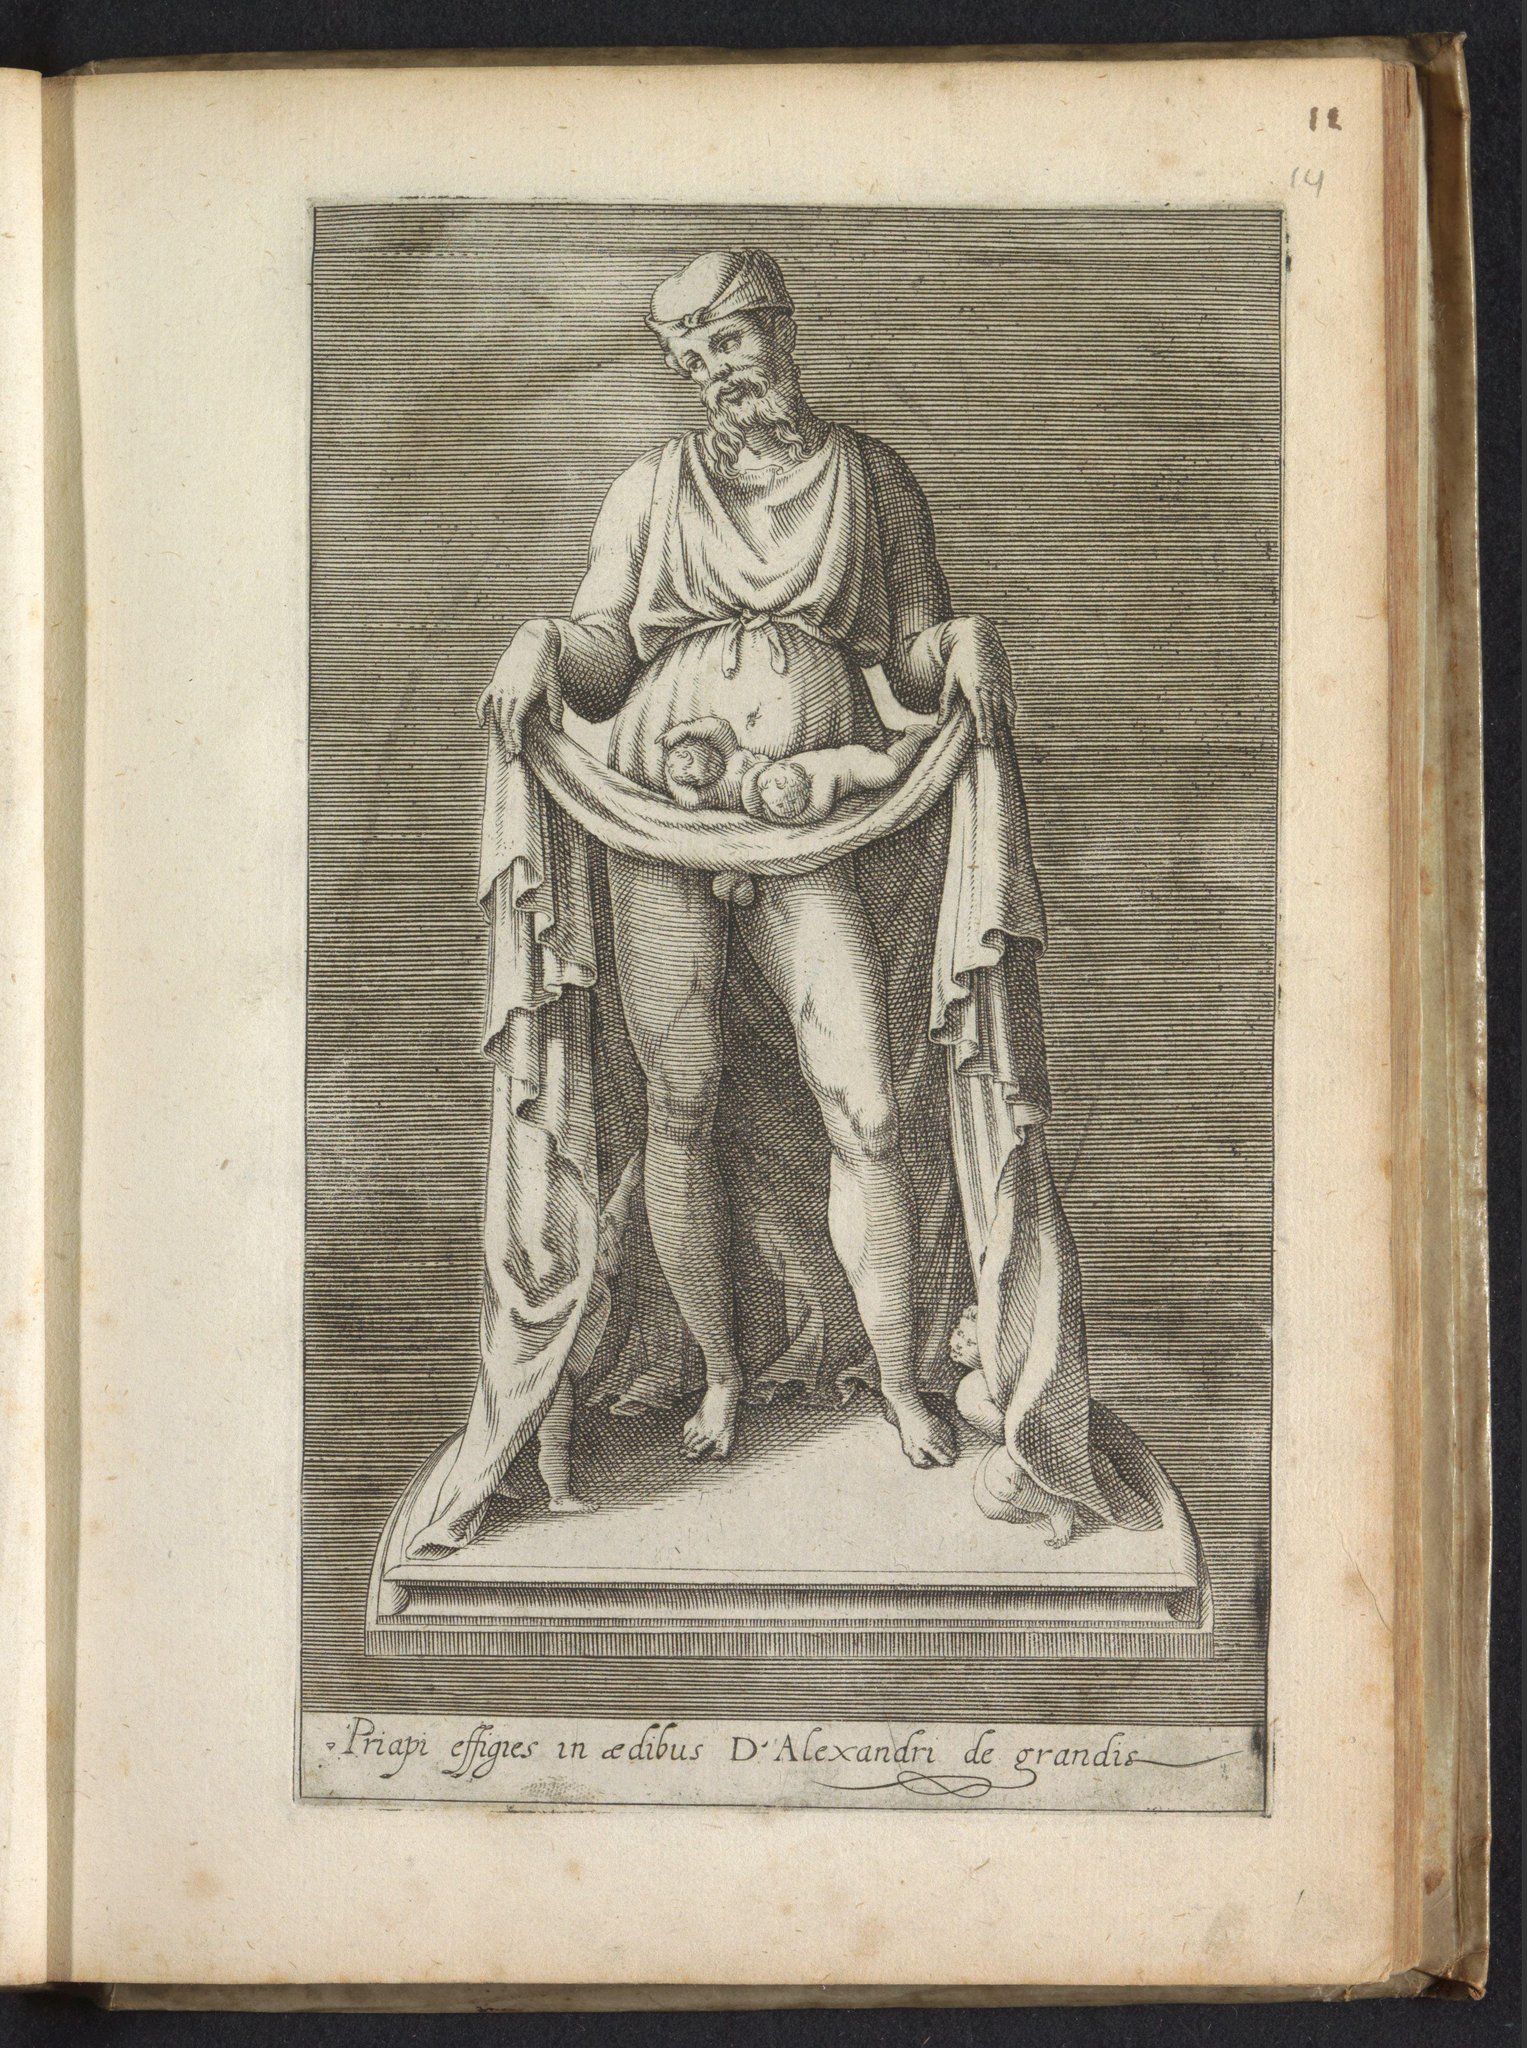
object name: album leaf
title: Antiquarum statuarum urbis Romae quae in publicis locis visuntur icones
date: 1584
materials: paper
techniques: engraving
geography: rome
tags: (story of) priapus, piece of sculpture, reproduction of a piece of sculpture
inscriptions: number: ‘11’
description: Deze prent maakt deel uit van een set van 79 prenten (+ titelprent) met voorstellingen van antieke sculpturen in Rome.